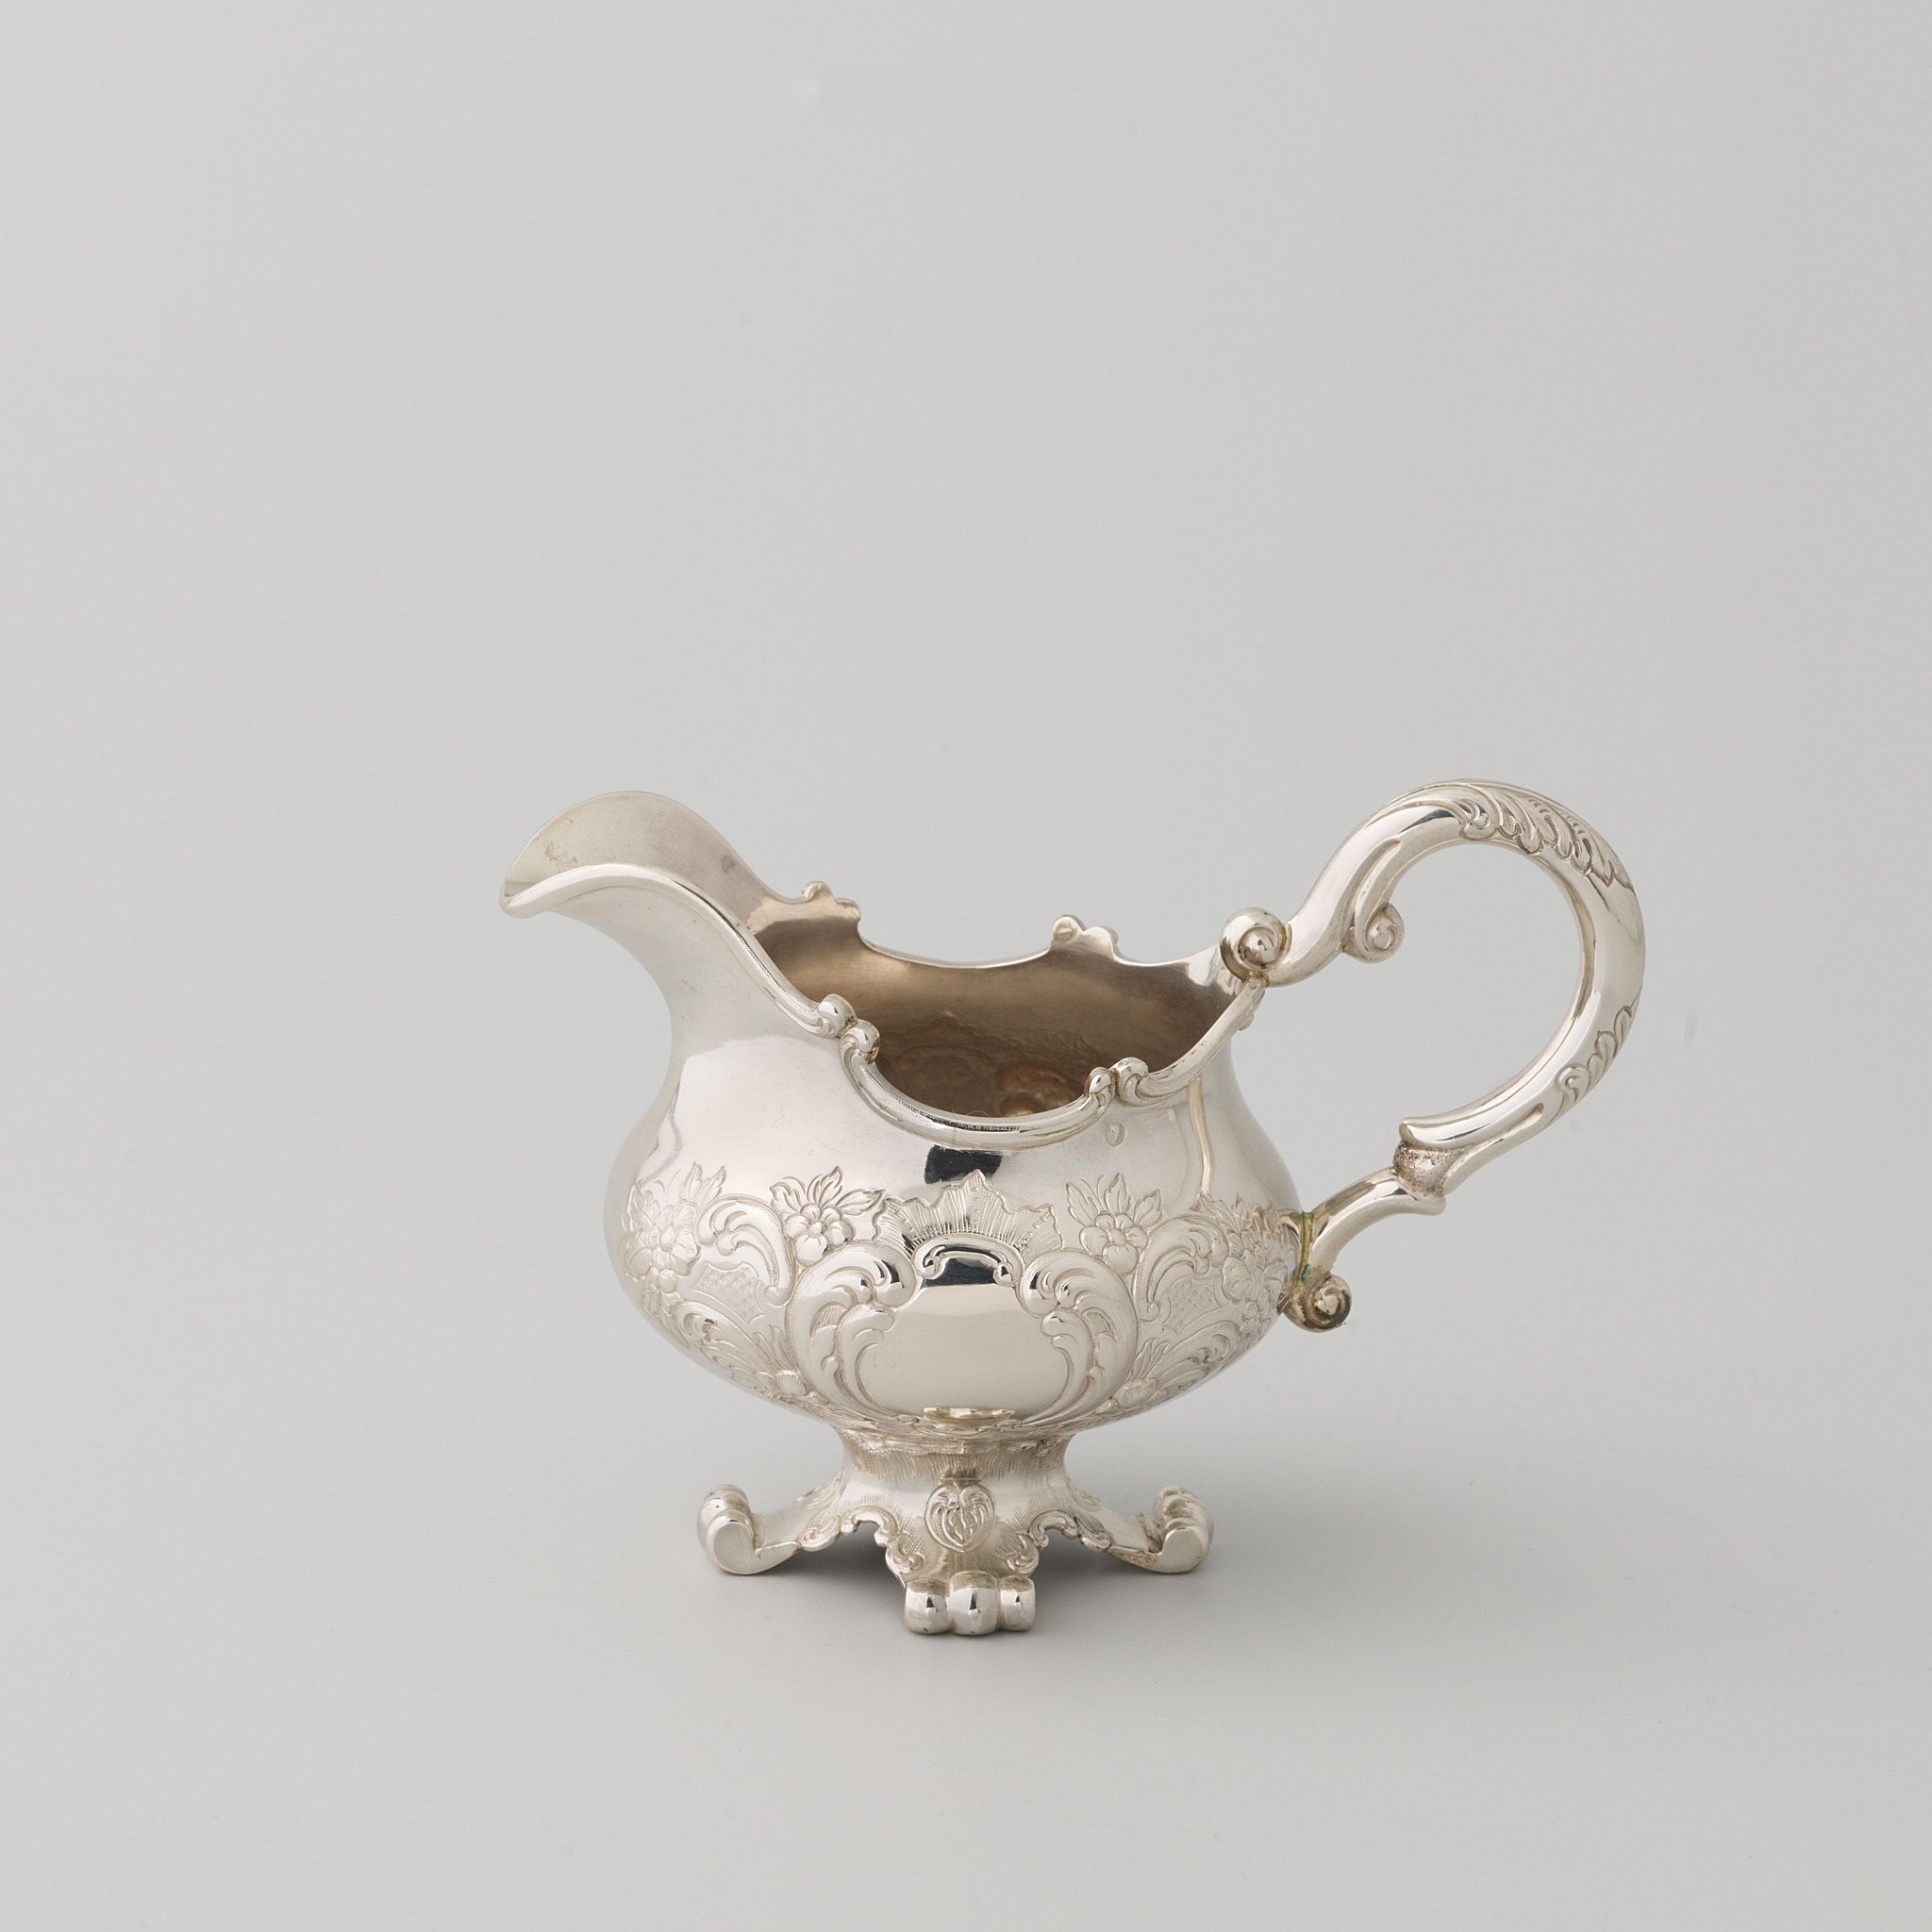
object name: tea service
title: Melkkan met drijfwerk en gravering in Louis XV stijl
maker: daniel jan de haas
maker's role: silversmith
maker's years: 1821-1886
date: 1865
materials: silver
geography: amsterdam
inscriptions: date letter: ‘F’, retailer's mark: ‘A.D. VERSCHUUR’, maker's mark, alloy mark, assay office mark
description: Coffee pot and four-piece tea service. Silver and ivory. Amsterdam, 1863, 1865, by Daniel Jan de Haas, designed by A.D. Verschuur